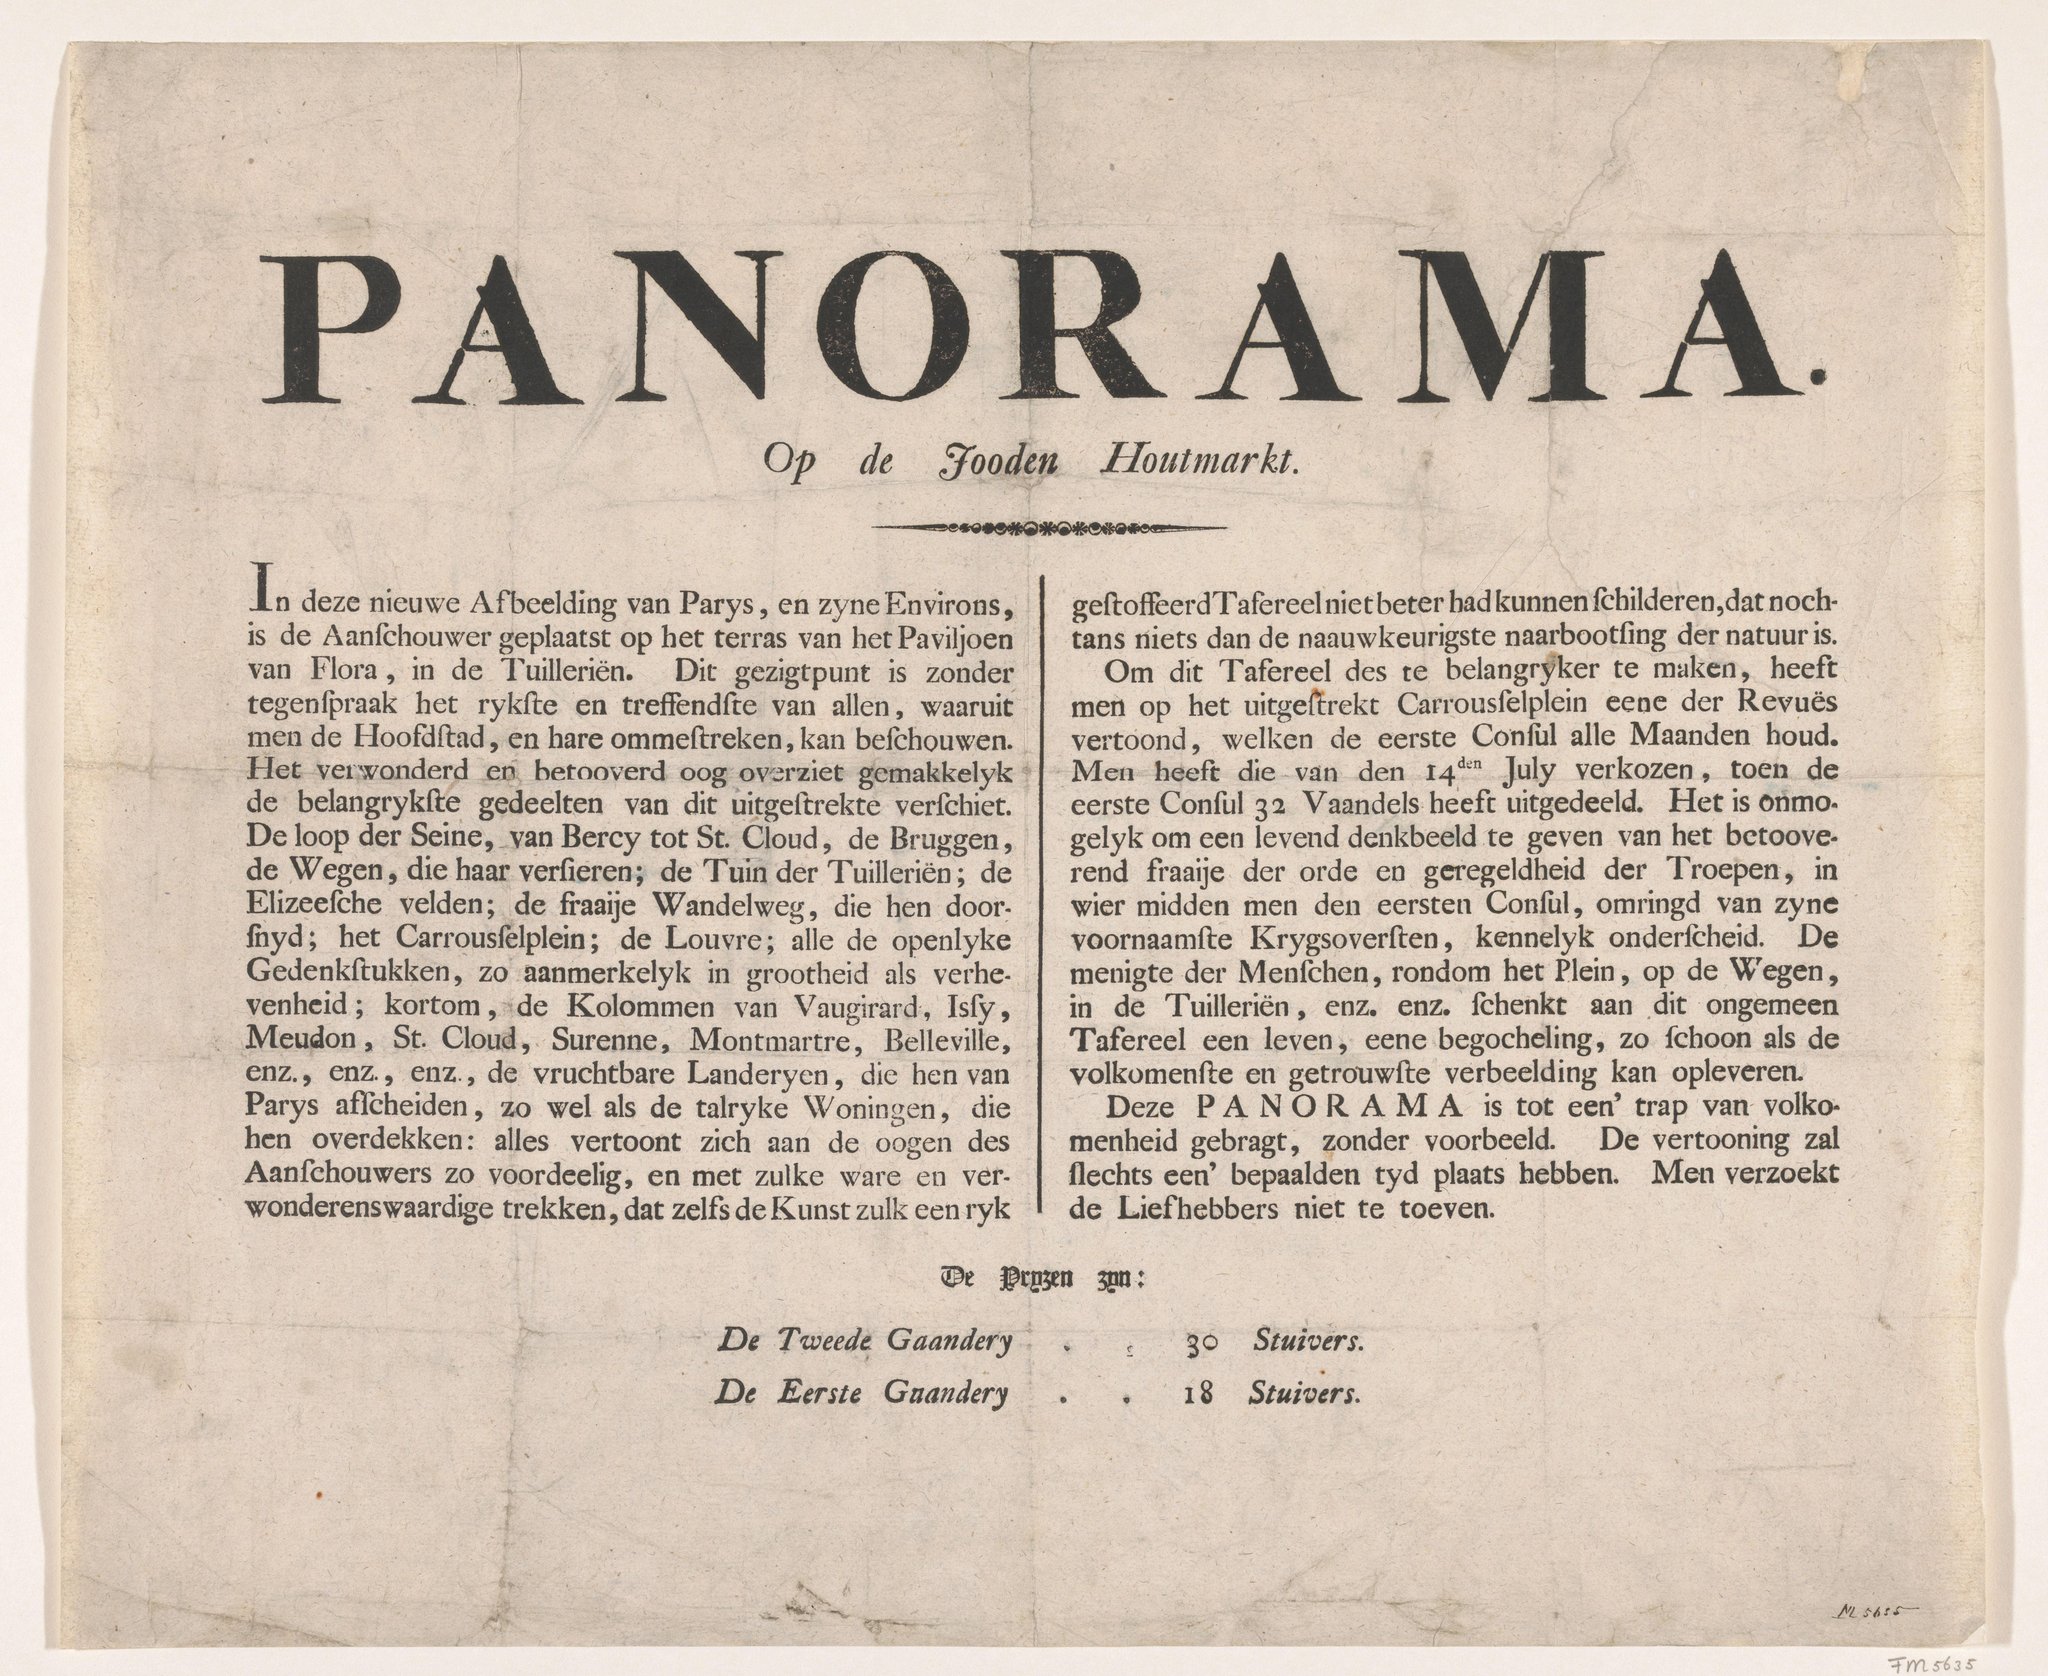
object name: text sheet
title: Aanplakbiljet voor het Panorama van Parijs, 1803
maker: Anonymous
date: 1803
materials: paper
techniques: letterpress printing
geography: amsterdam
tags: jonas daniël meijerplein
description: Aanplakbiljet voor het bezichten van het geschilderde Panorama van Parijs. Het panorama was te bezichtigen van september 1803 tot april 1804 op de Houtmarkt (het huidige Jonas Daniël Meijerplein) te Amsterdam. Tekst met een beschrijving van het panorama van de stad en toegangsprijzen.